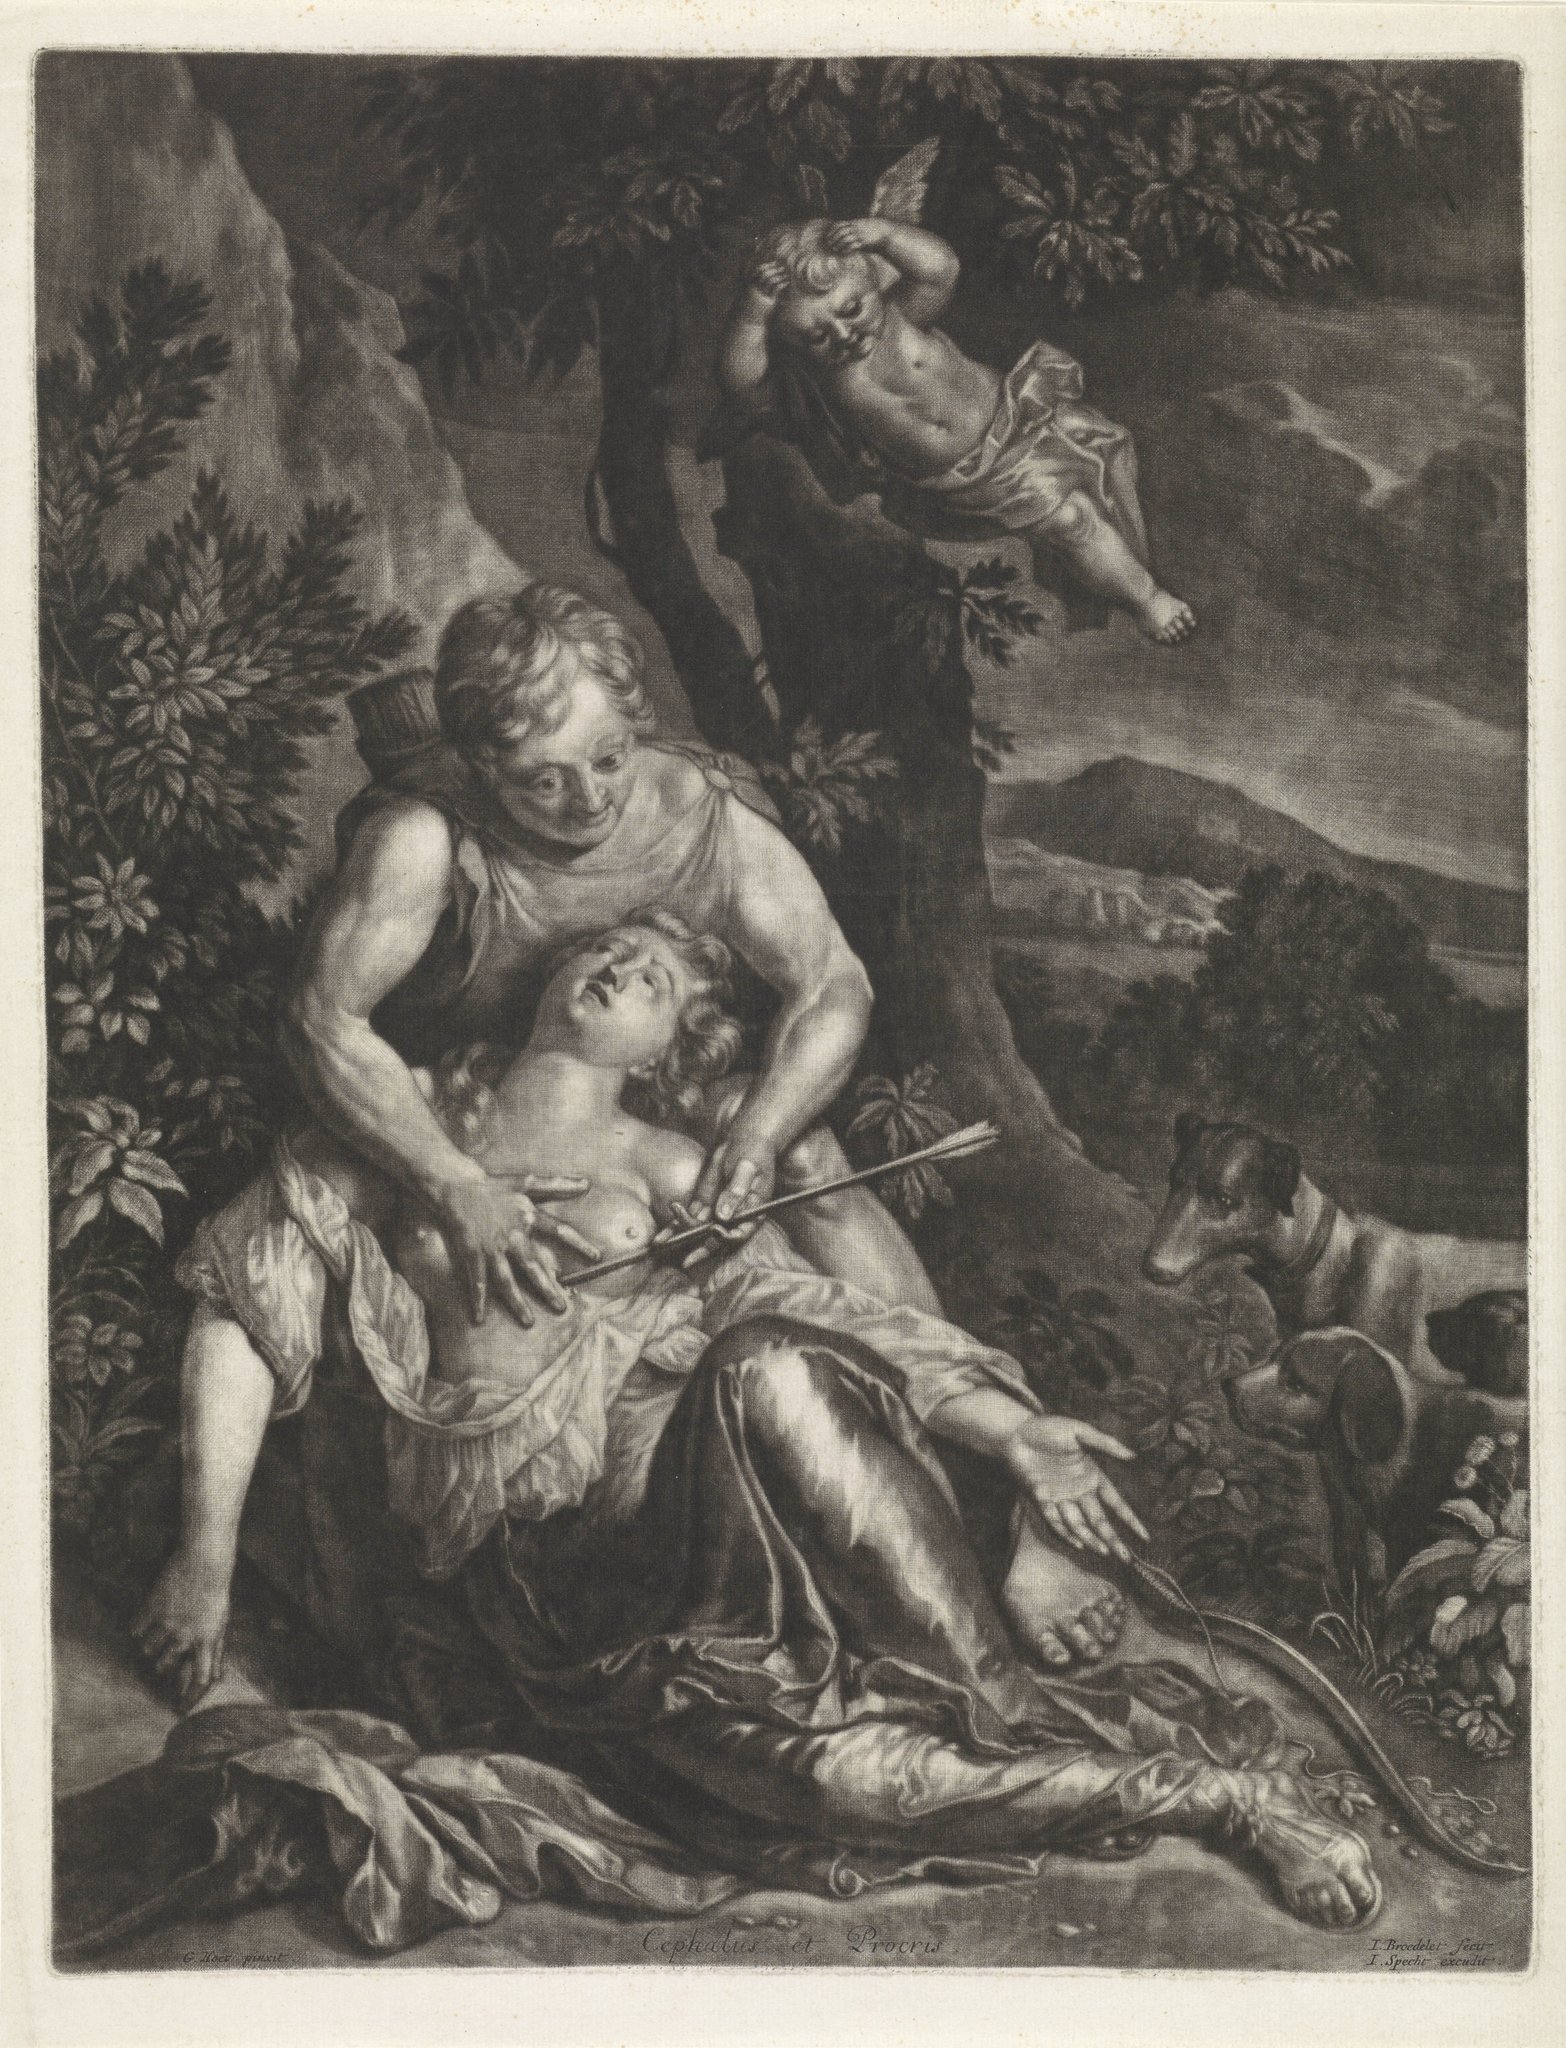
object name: print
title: Cephalus en Procris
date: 1670-1700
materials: paper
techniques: engraving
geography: utrecht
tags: cephalus and procris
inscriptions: collector's mark: Lugt 2228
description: In een landschap probeert Procris zijn geliefde Cephalus van de dood te redden, nadat hij haar per ongelukt doorboorde met een pijl tijdens de jacht. Ze sterft in zijn armen.